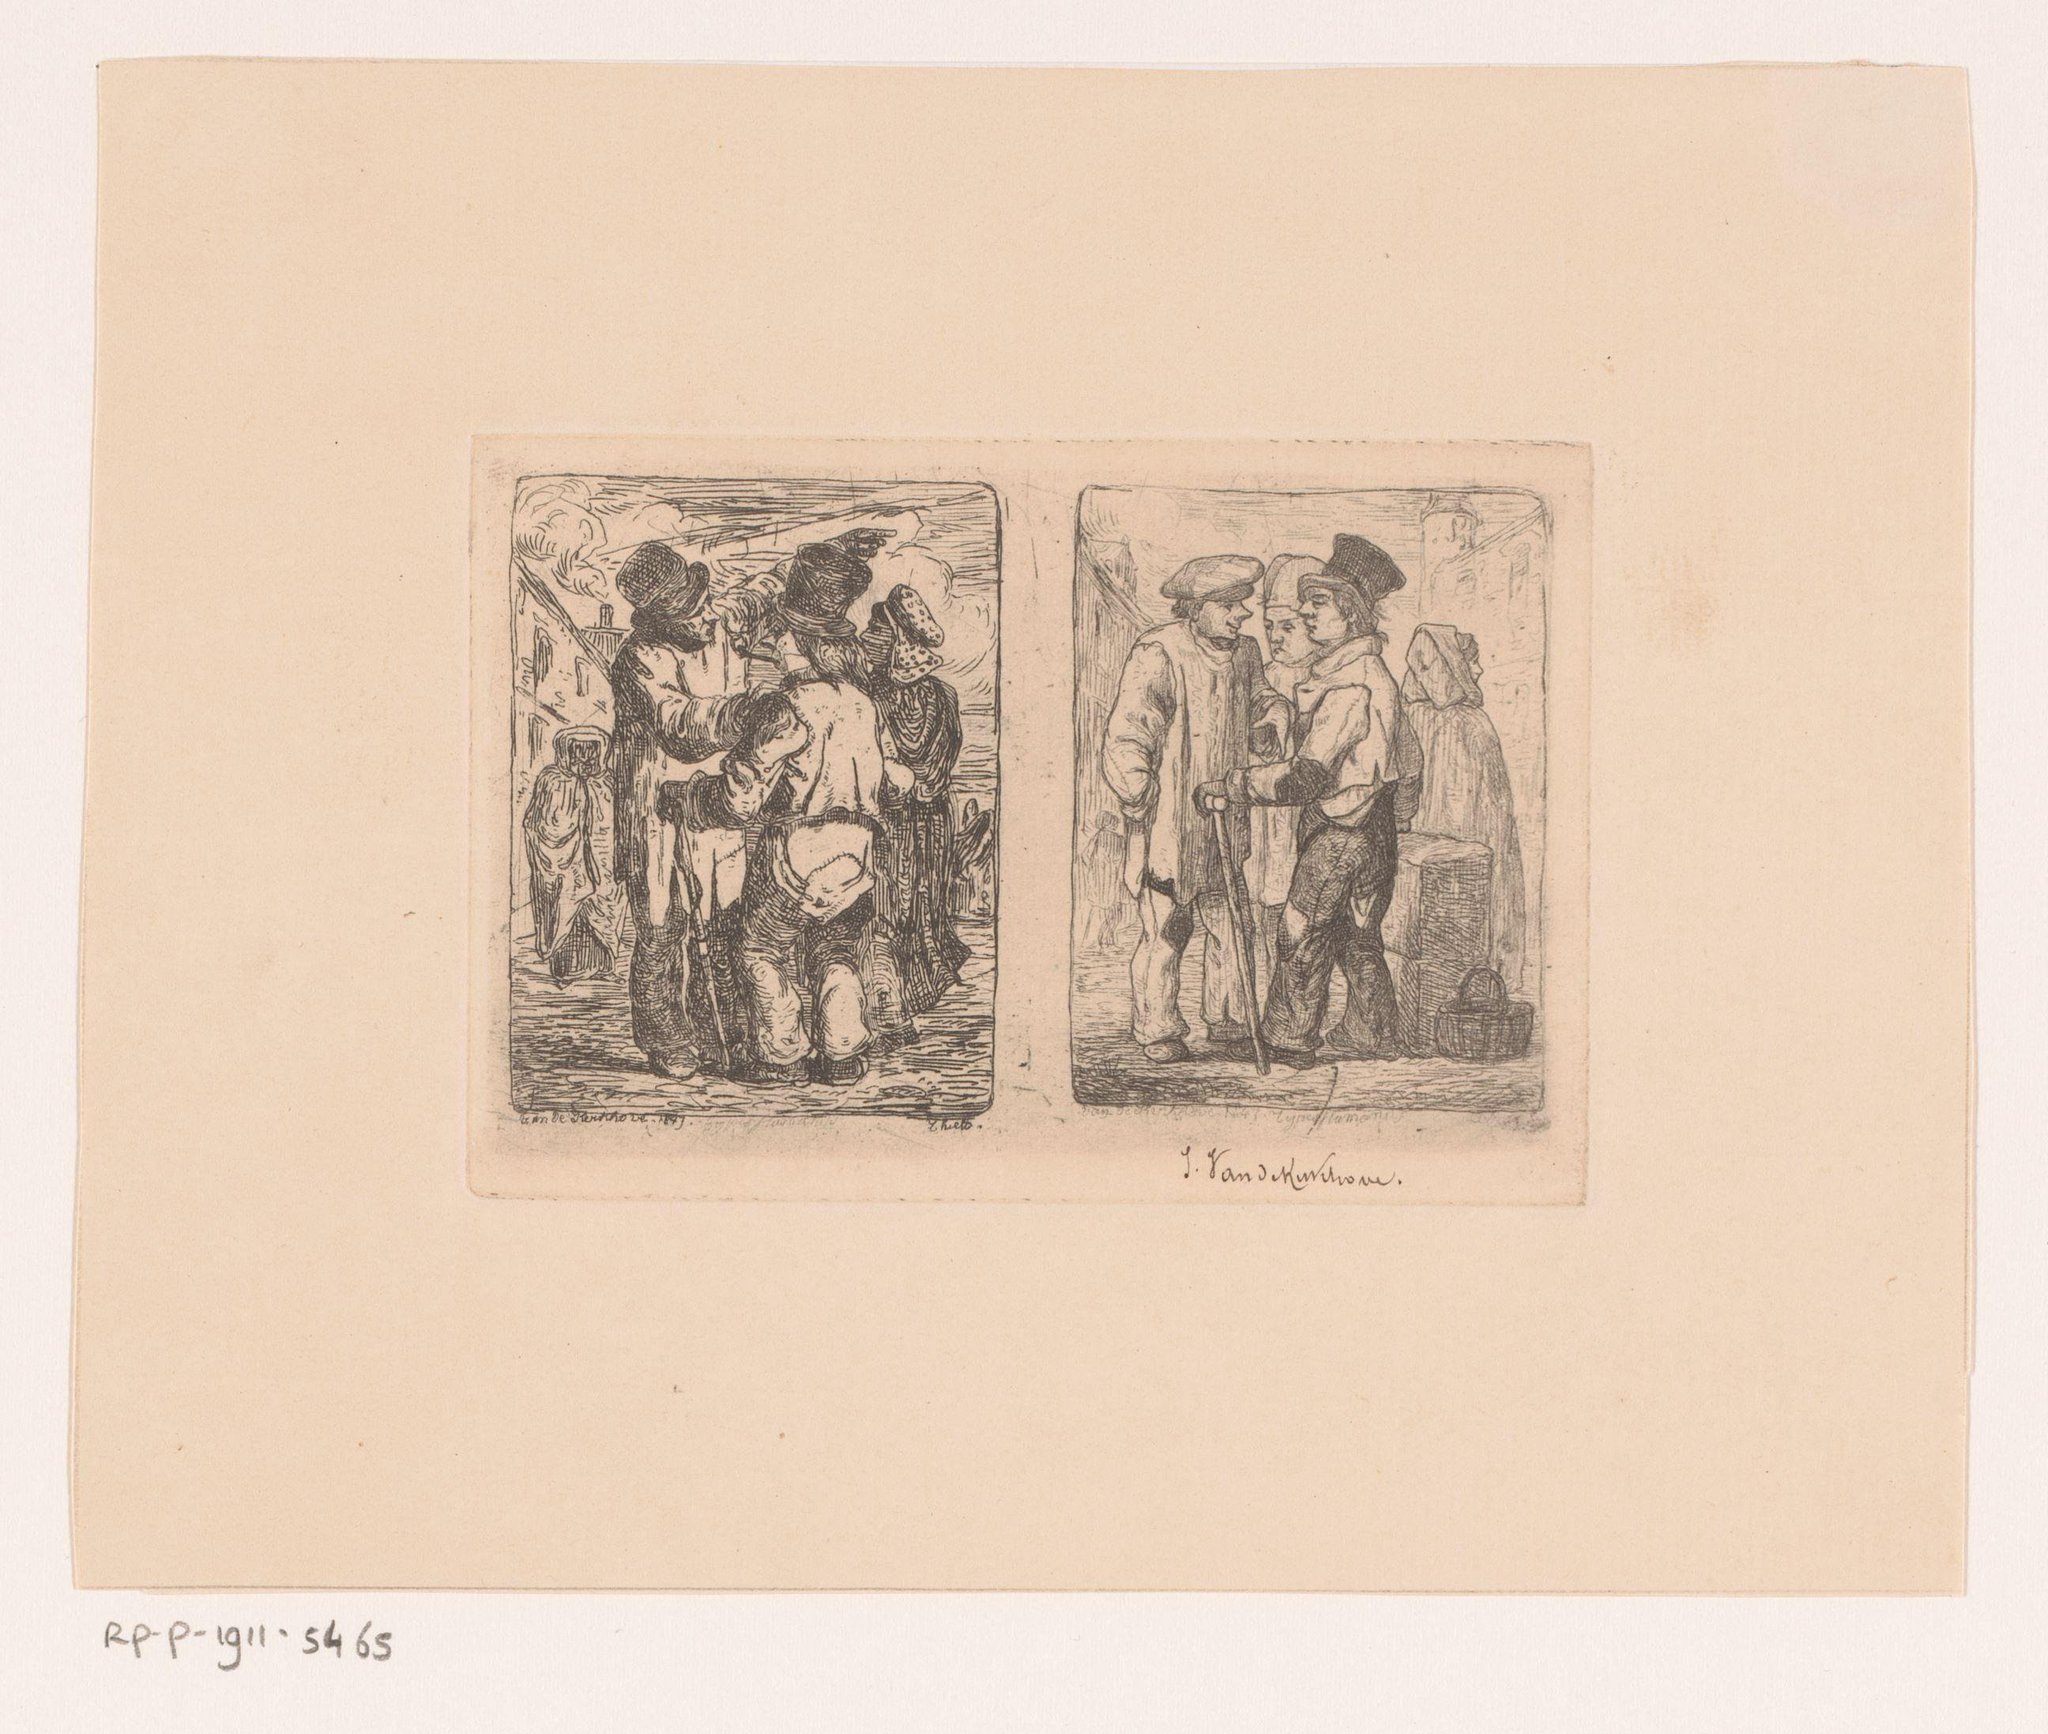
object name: print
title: Twee voorstellingen van een groep figuren op straat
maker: jan van de kerkhove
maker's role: print maker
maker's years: 1822-1881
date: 1847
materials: paper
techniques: etching, intaglio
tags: head-gear, walking-stick, staff, index finger forwards, pointing, indicating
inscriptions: collector's mark: Lugt 2228